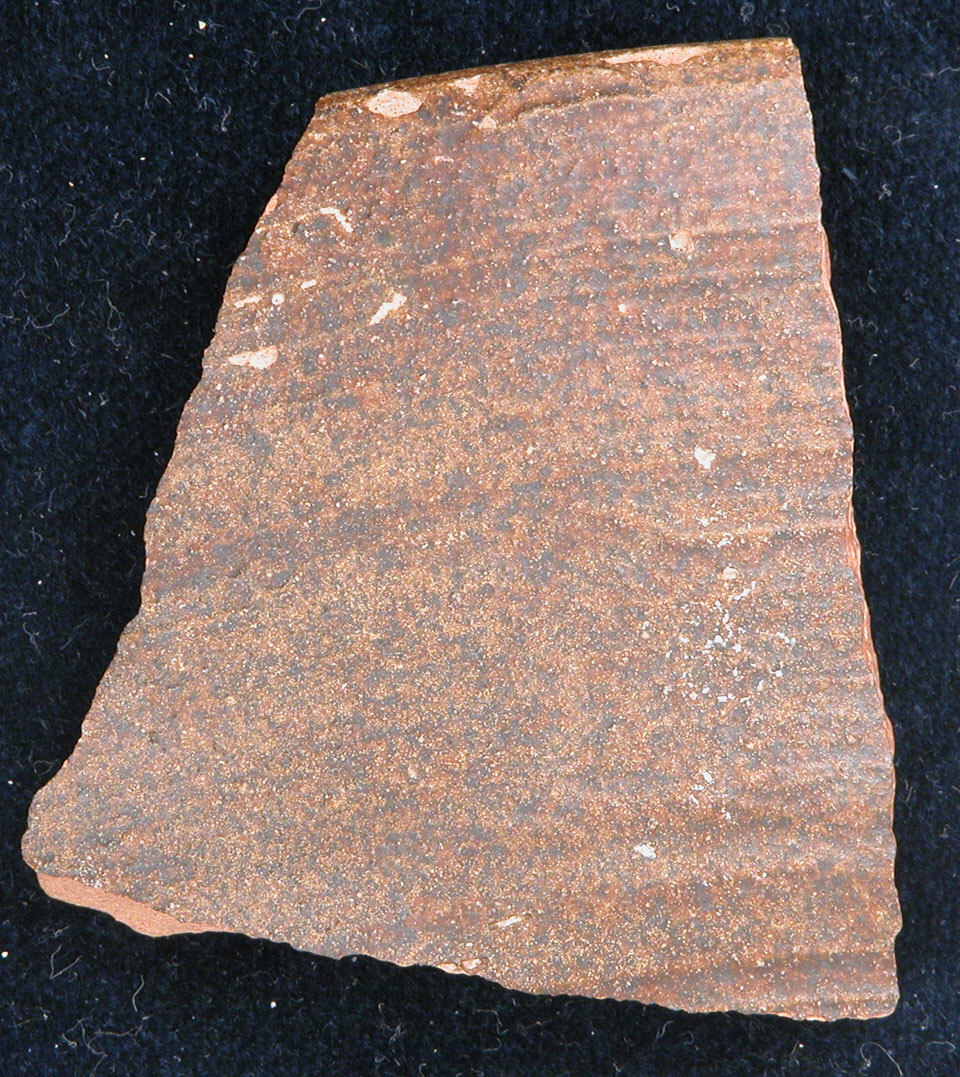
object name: fragment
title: Ceramic Fragment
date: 801-1000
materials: earthenware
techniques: glazing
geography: saudi arabia